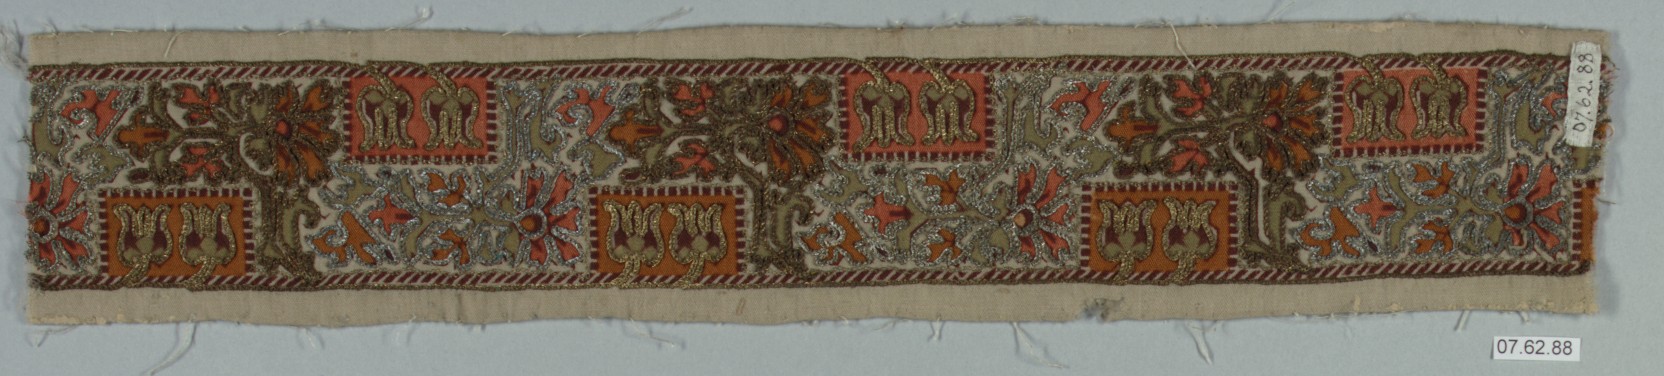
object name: textile fragment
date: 1801-1900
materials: metal thread, silk, wool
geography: india